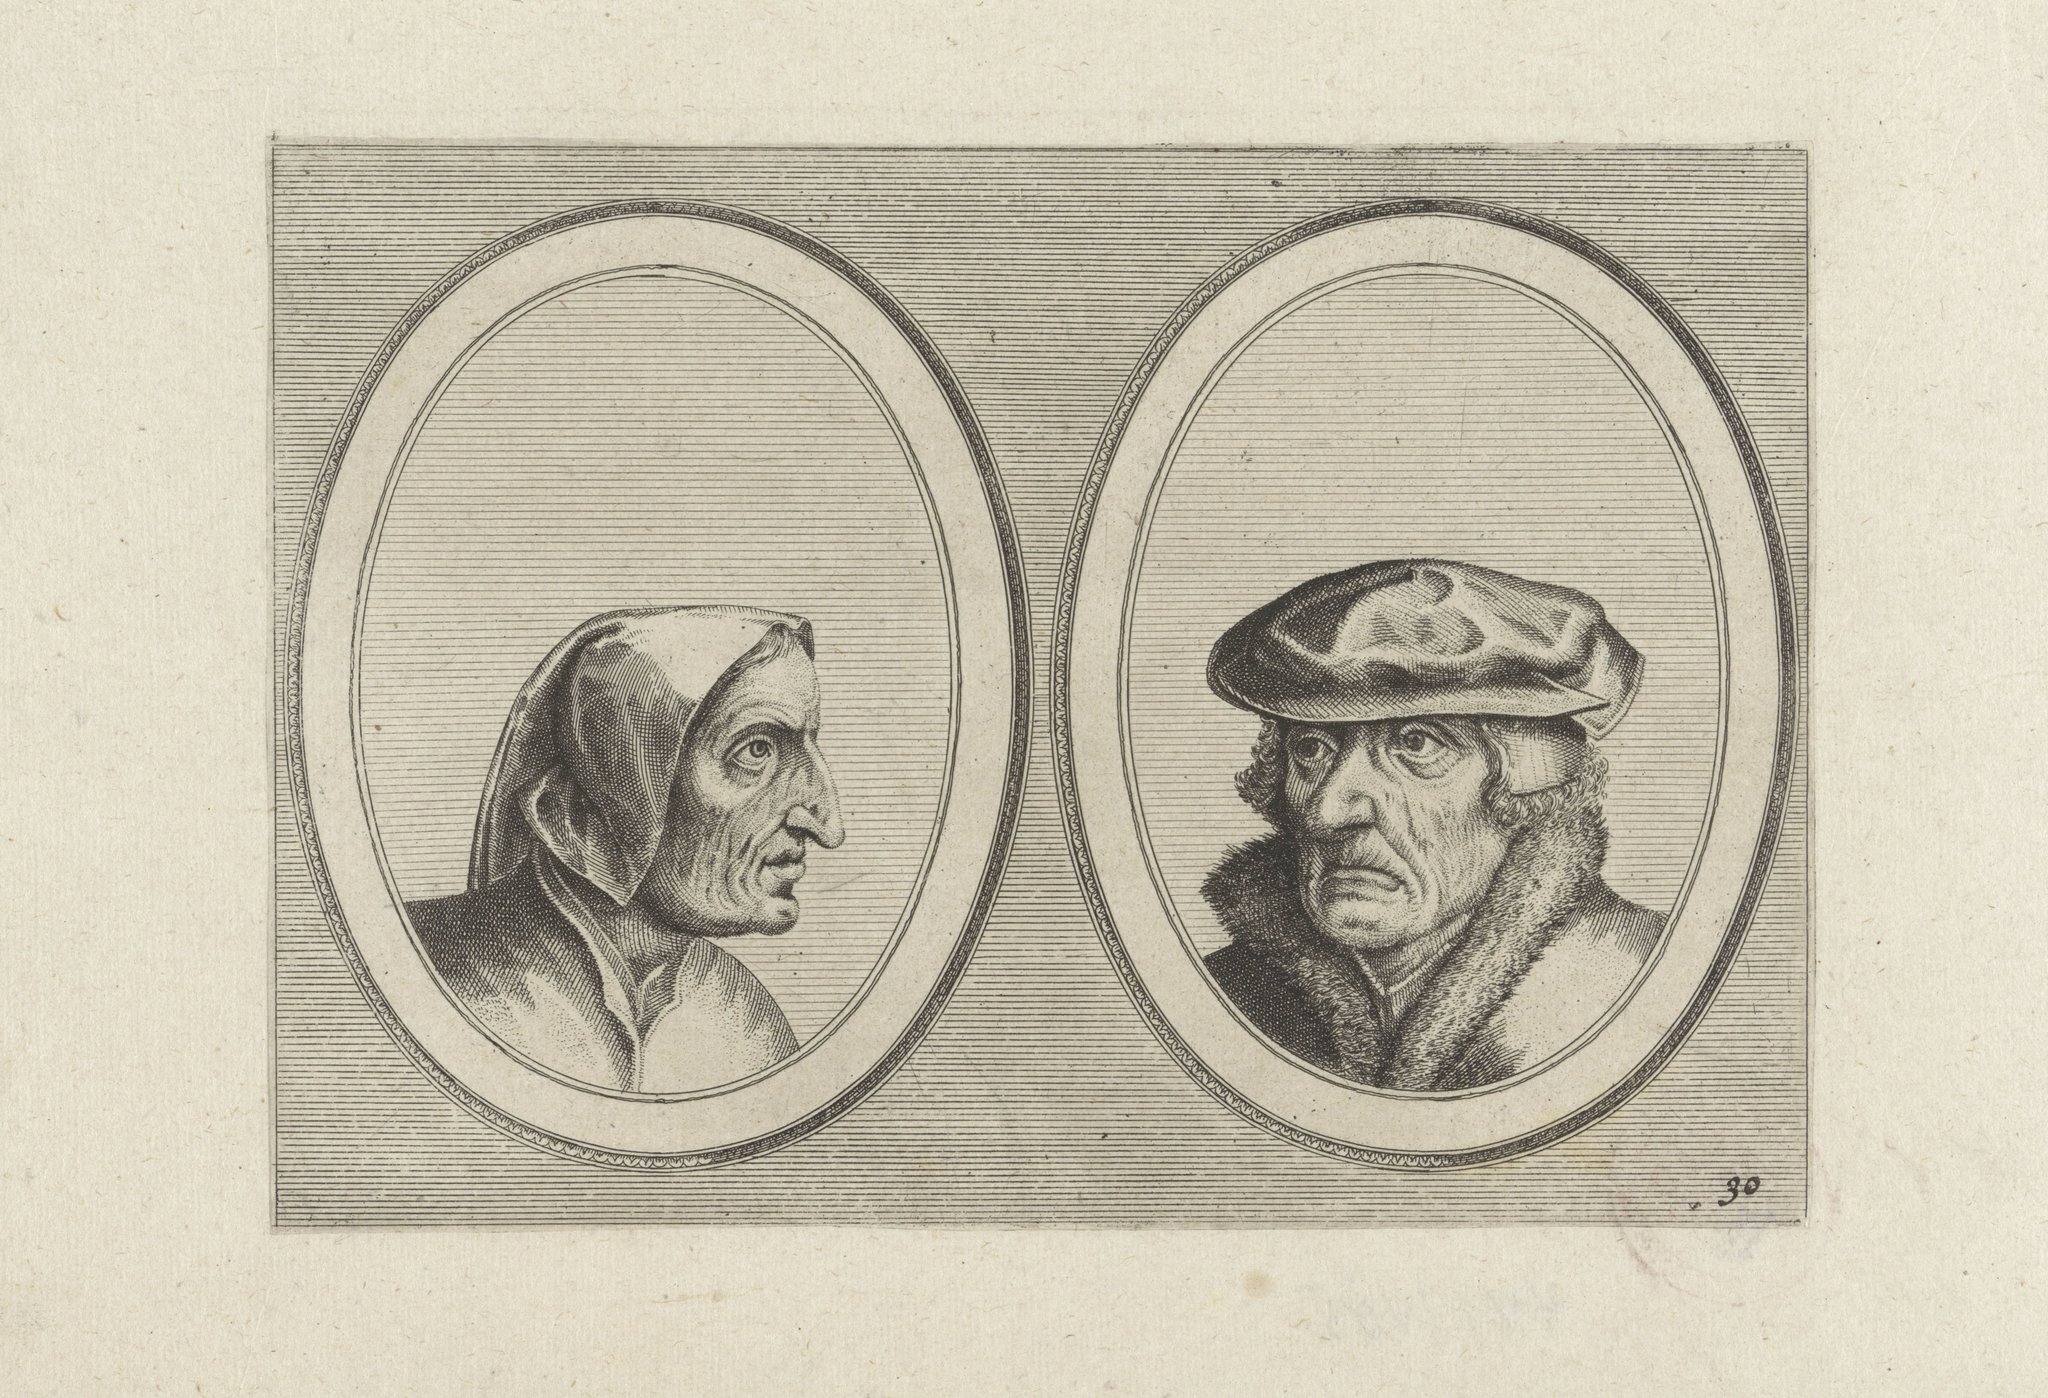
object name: print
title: Buyltje On-versaed en Waernar Altijdt-meer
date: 1612-1652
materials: paper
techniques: engraving, etching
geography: amsterdam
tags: head-gear, farmers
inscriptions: collector's mark: Lugt 700, collector's mark: Lugt 240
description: Prent uit een serie van 36 prenten met koppen van boeren en boerinnen.